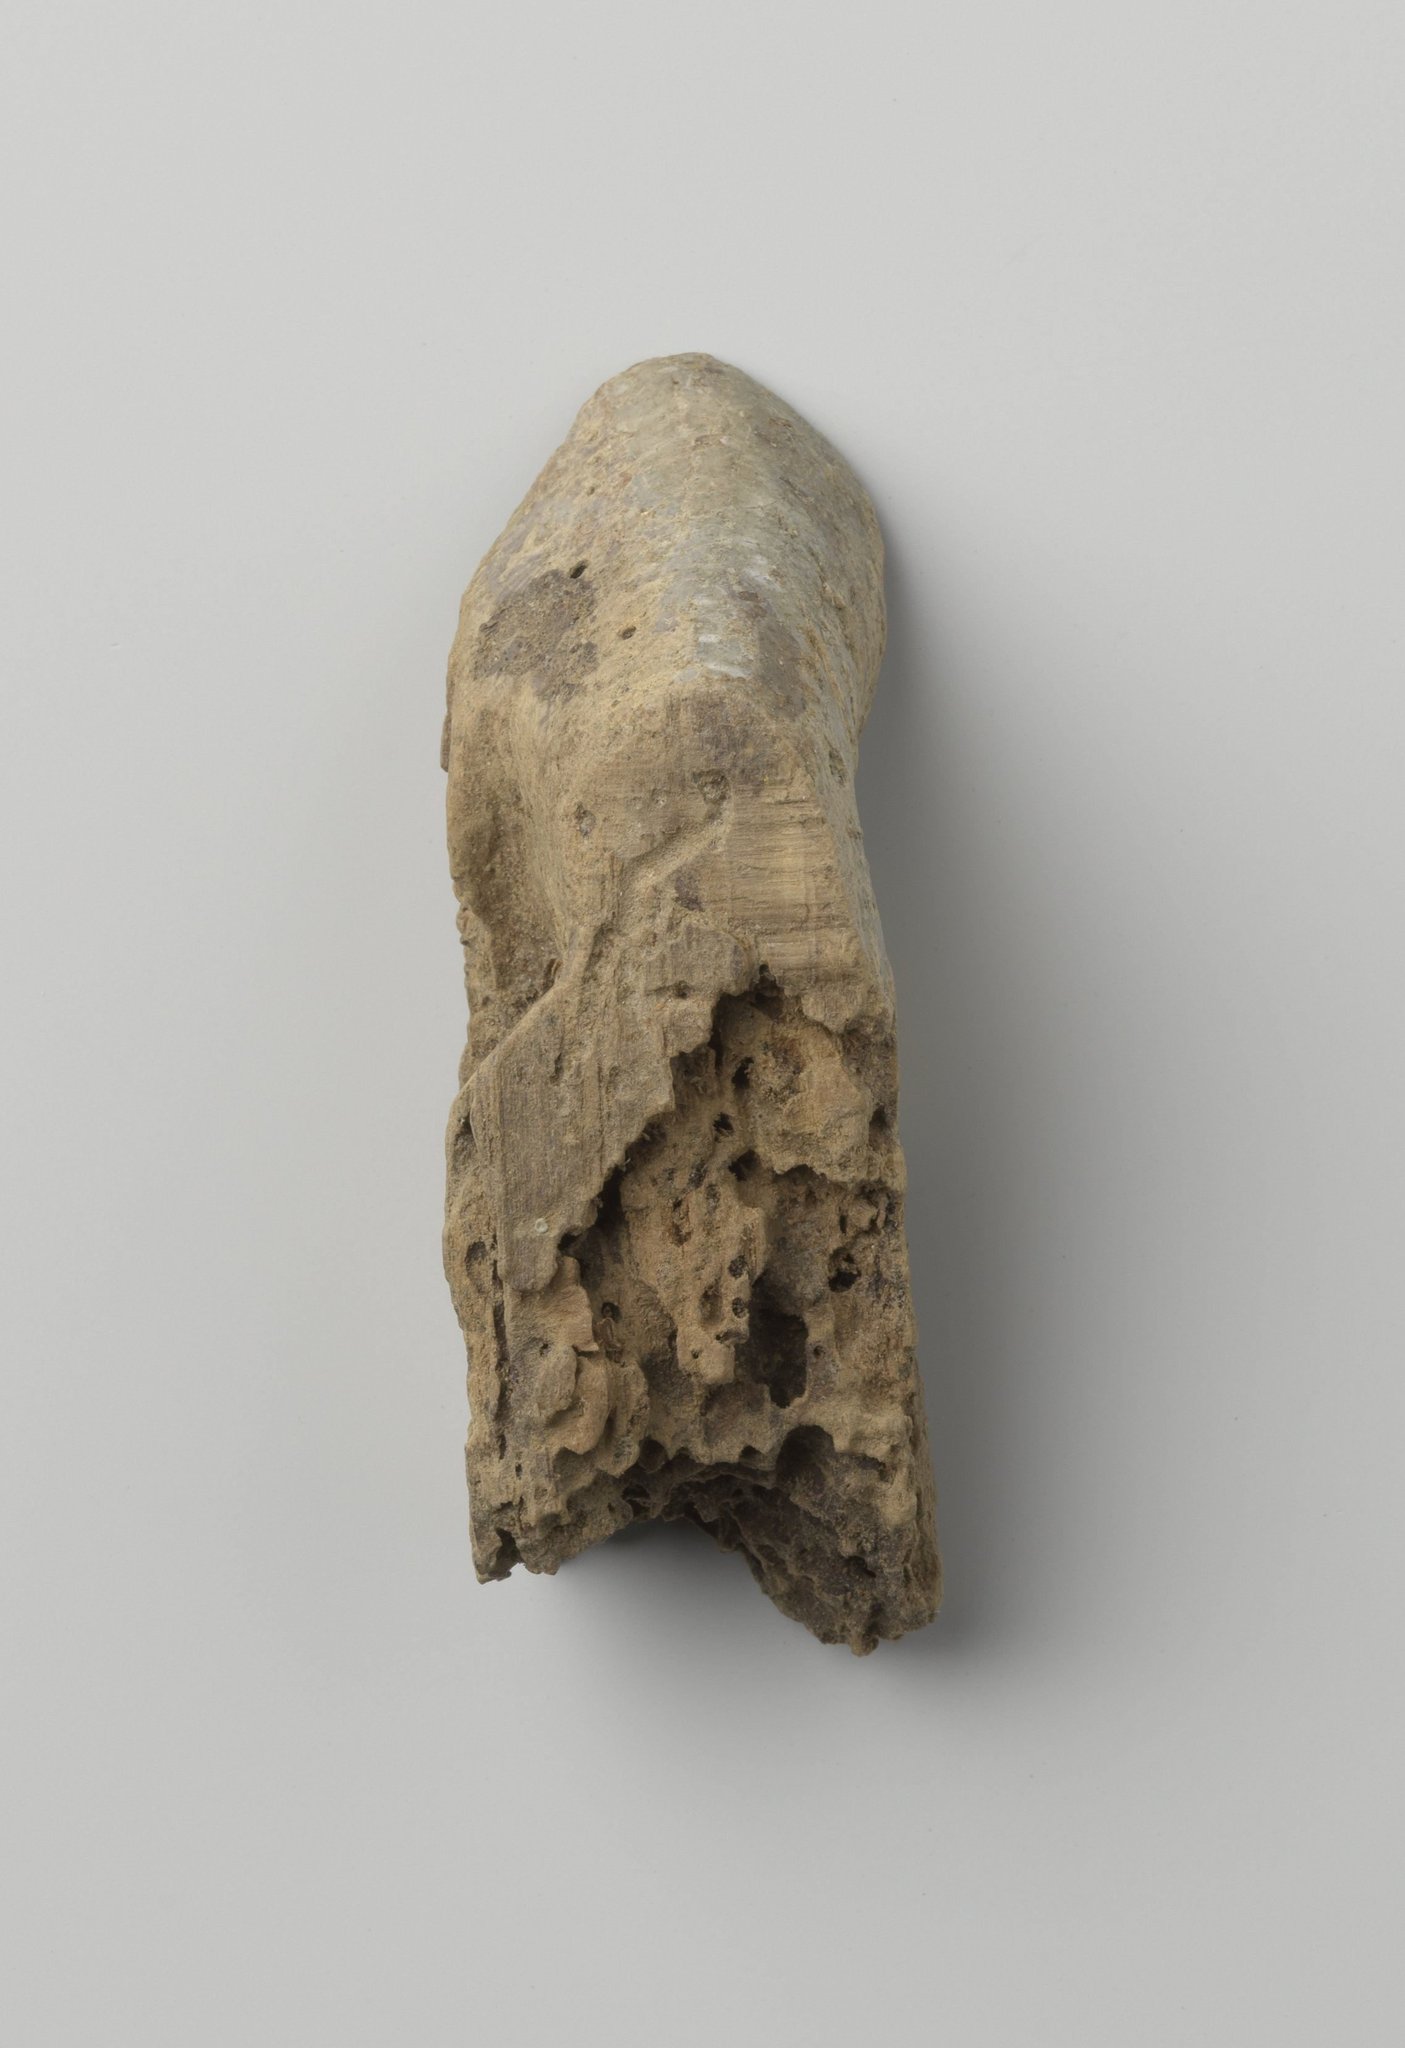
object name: fragment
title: Fragment; (mogelijk) behorend tot het retabel van Soest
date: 1475-1499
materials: wood